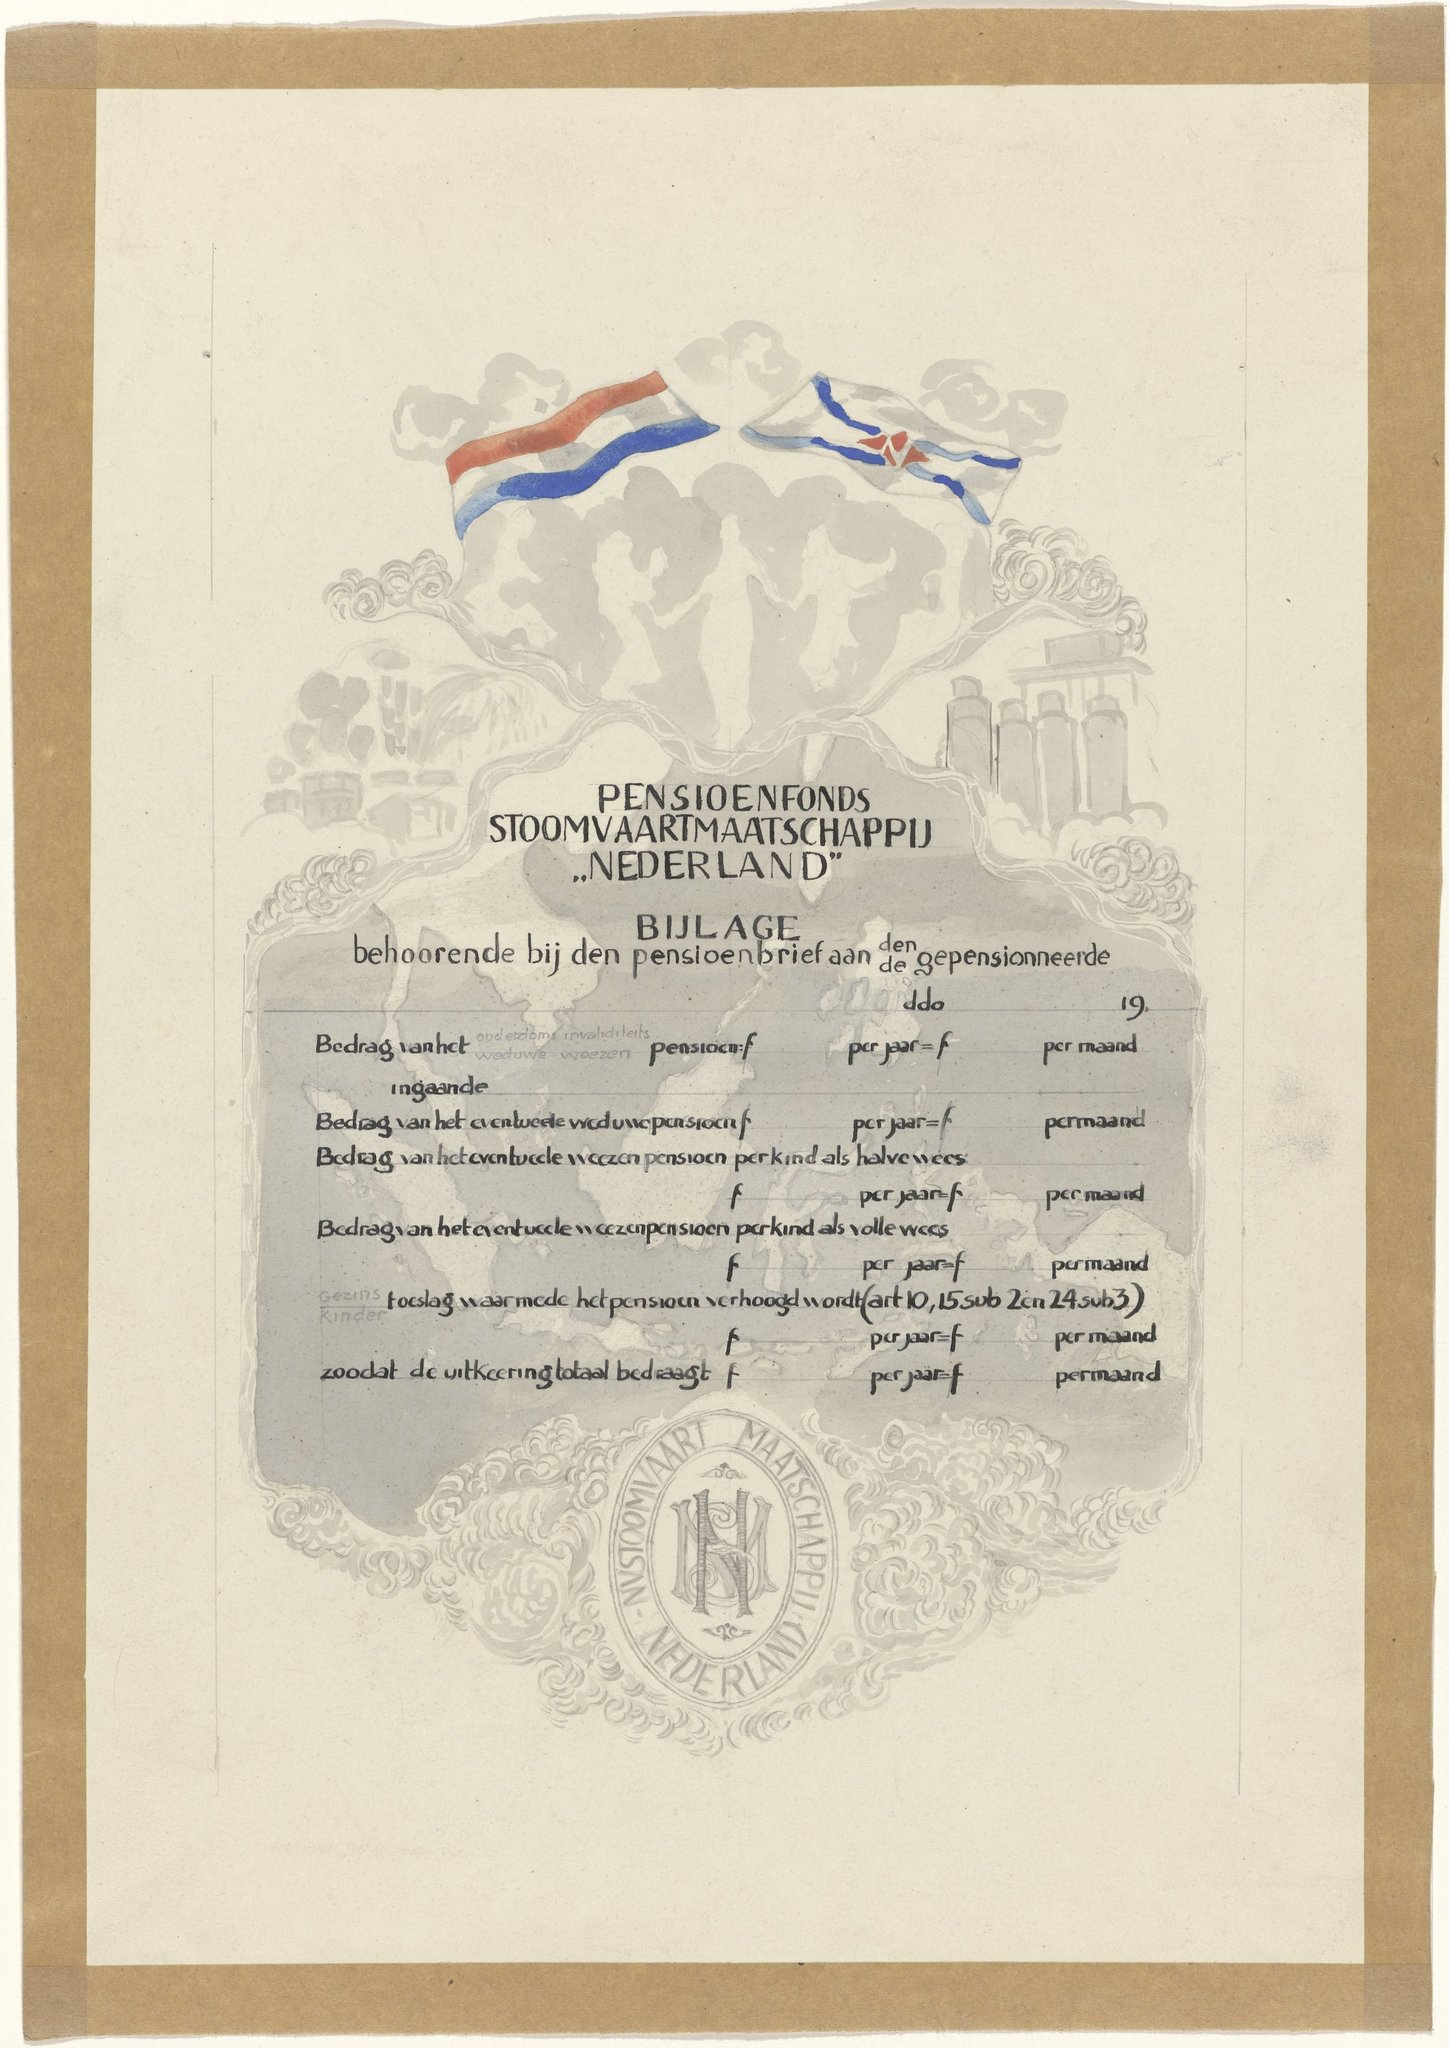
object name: drawing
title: Ontwerp voor de bijlage behorende bij de pensioenbrief van de Stoomvaart Maatschappij Nederland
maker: carel adolph lion cachet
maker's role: draughtsman, print maker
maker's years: 1864-1945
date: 1874-1945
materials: paper, pencil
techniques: brush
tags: names of organizations, companies, trade unions, etc.